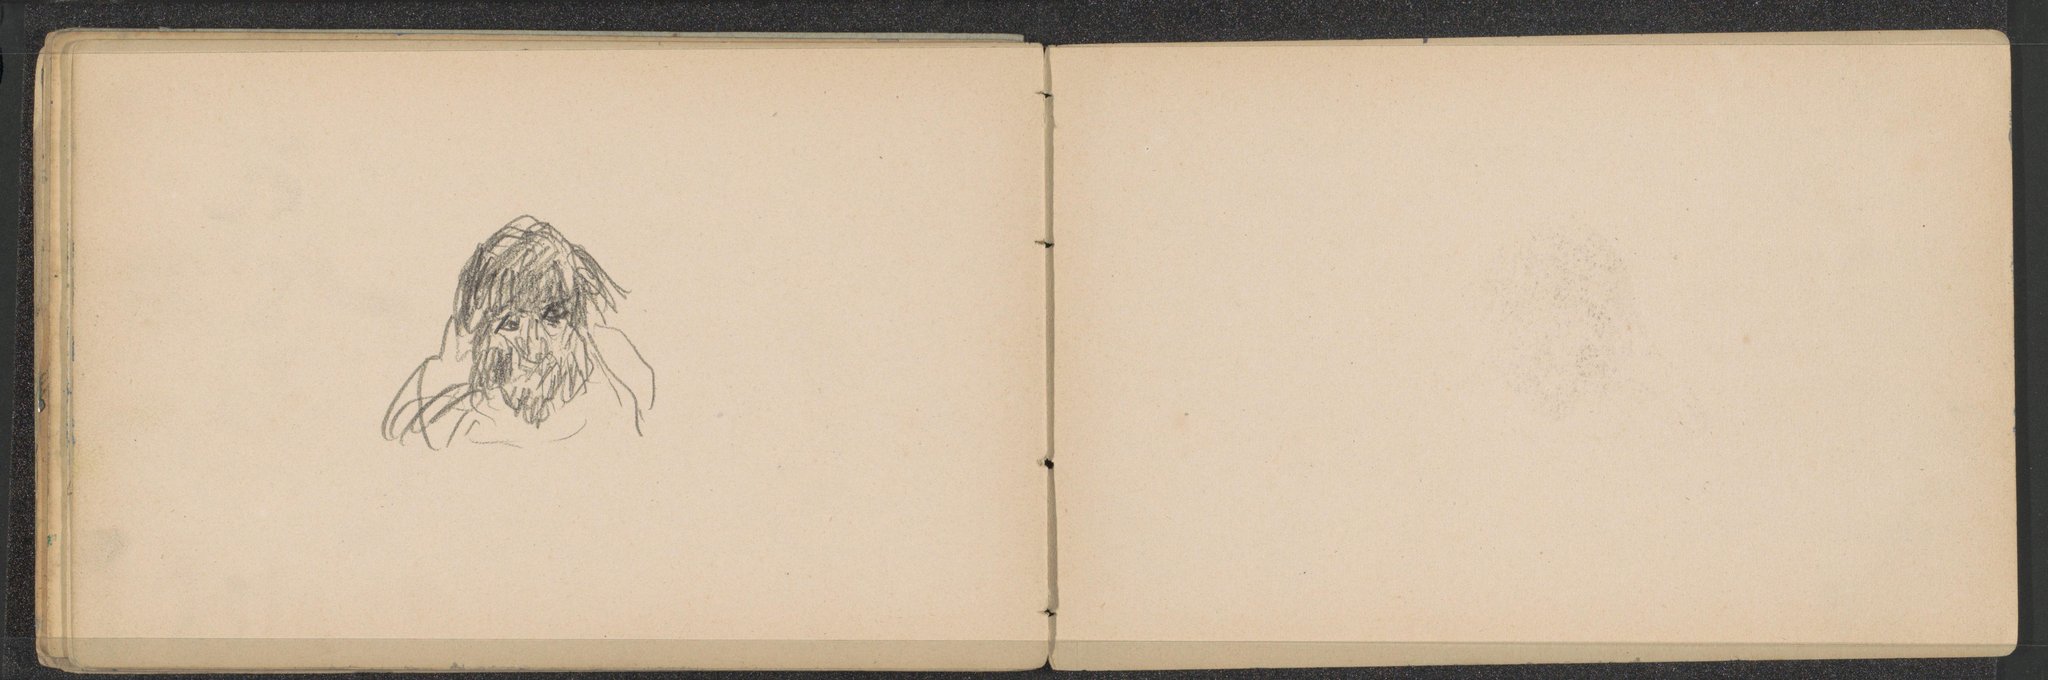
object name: sketchbook leaf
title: Man met baard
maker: louis apol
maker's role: draughtsman, painter, print maker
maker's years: 1850-1936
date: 1880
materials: chalk, paper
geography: novaya zemlya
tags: adult man, beard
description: Blad 34 verso uit een schetsboek met 35 bladen betekend tijdens de expeditie naar Nova Zembla in 1880.